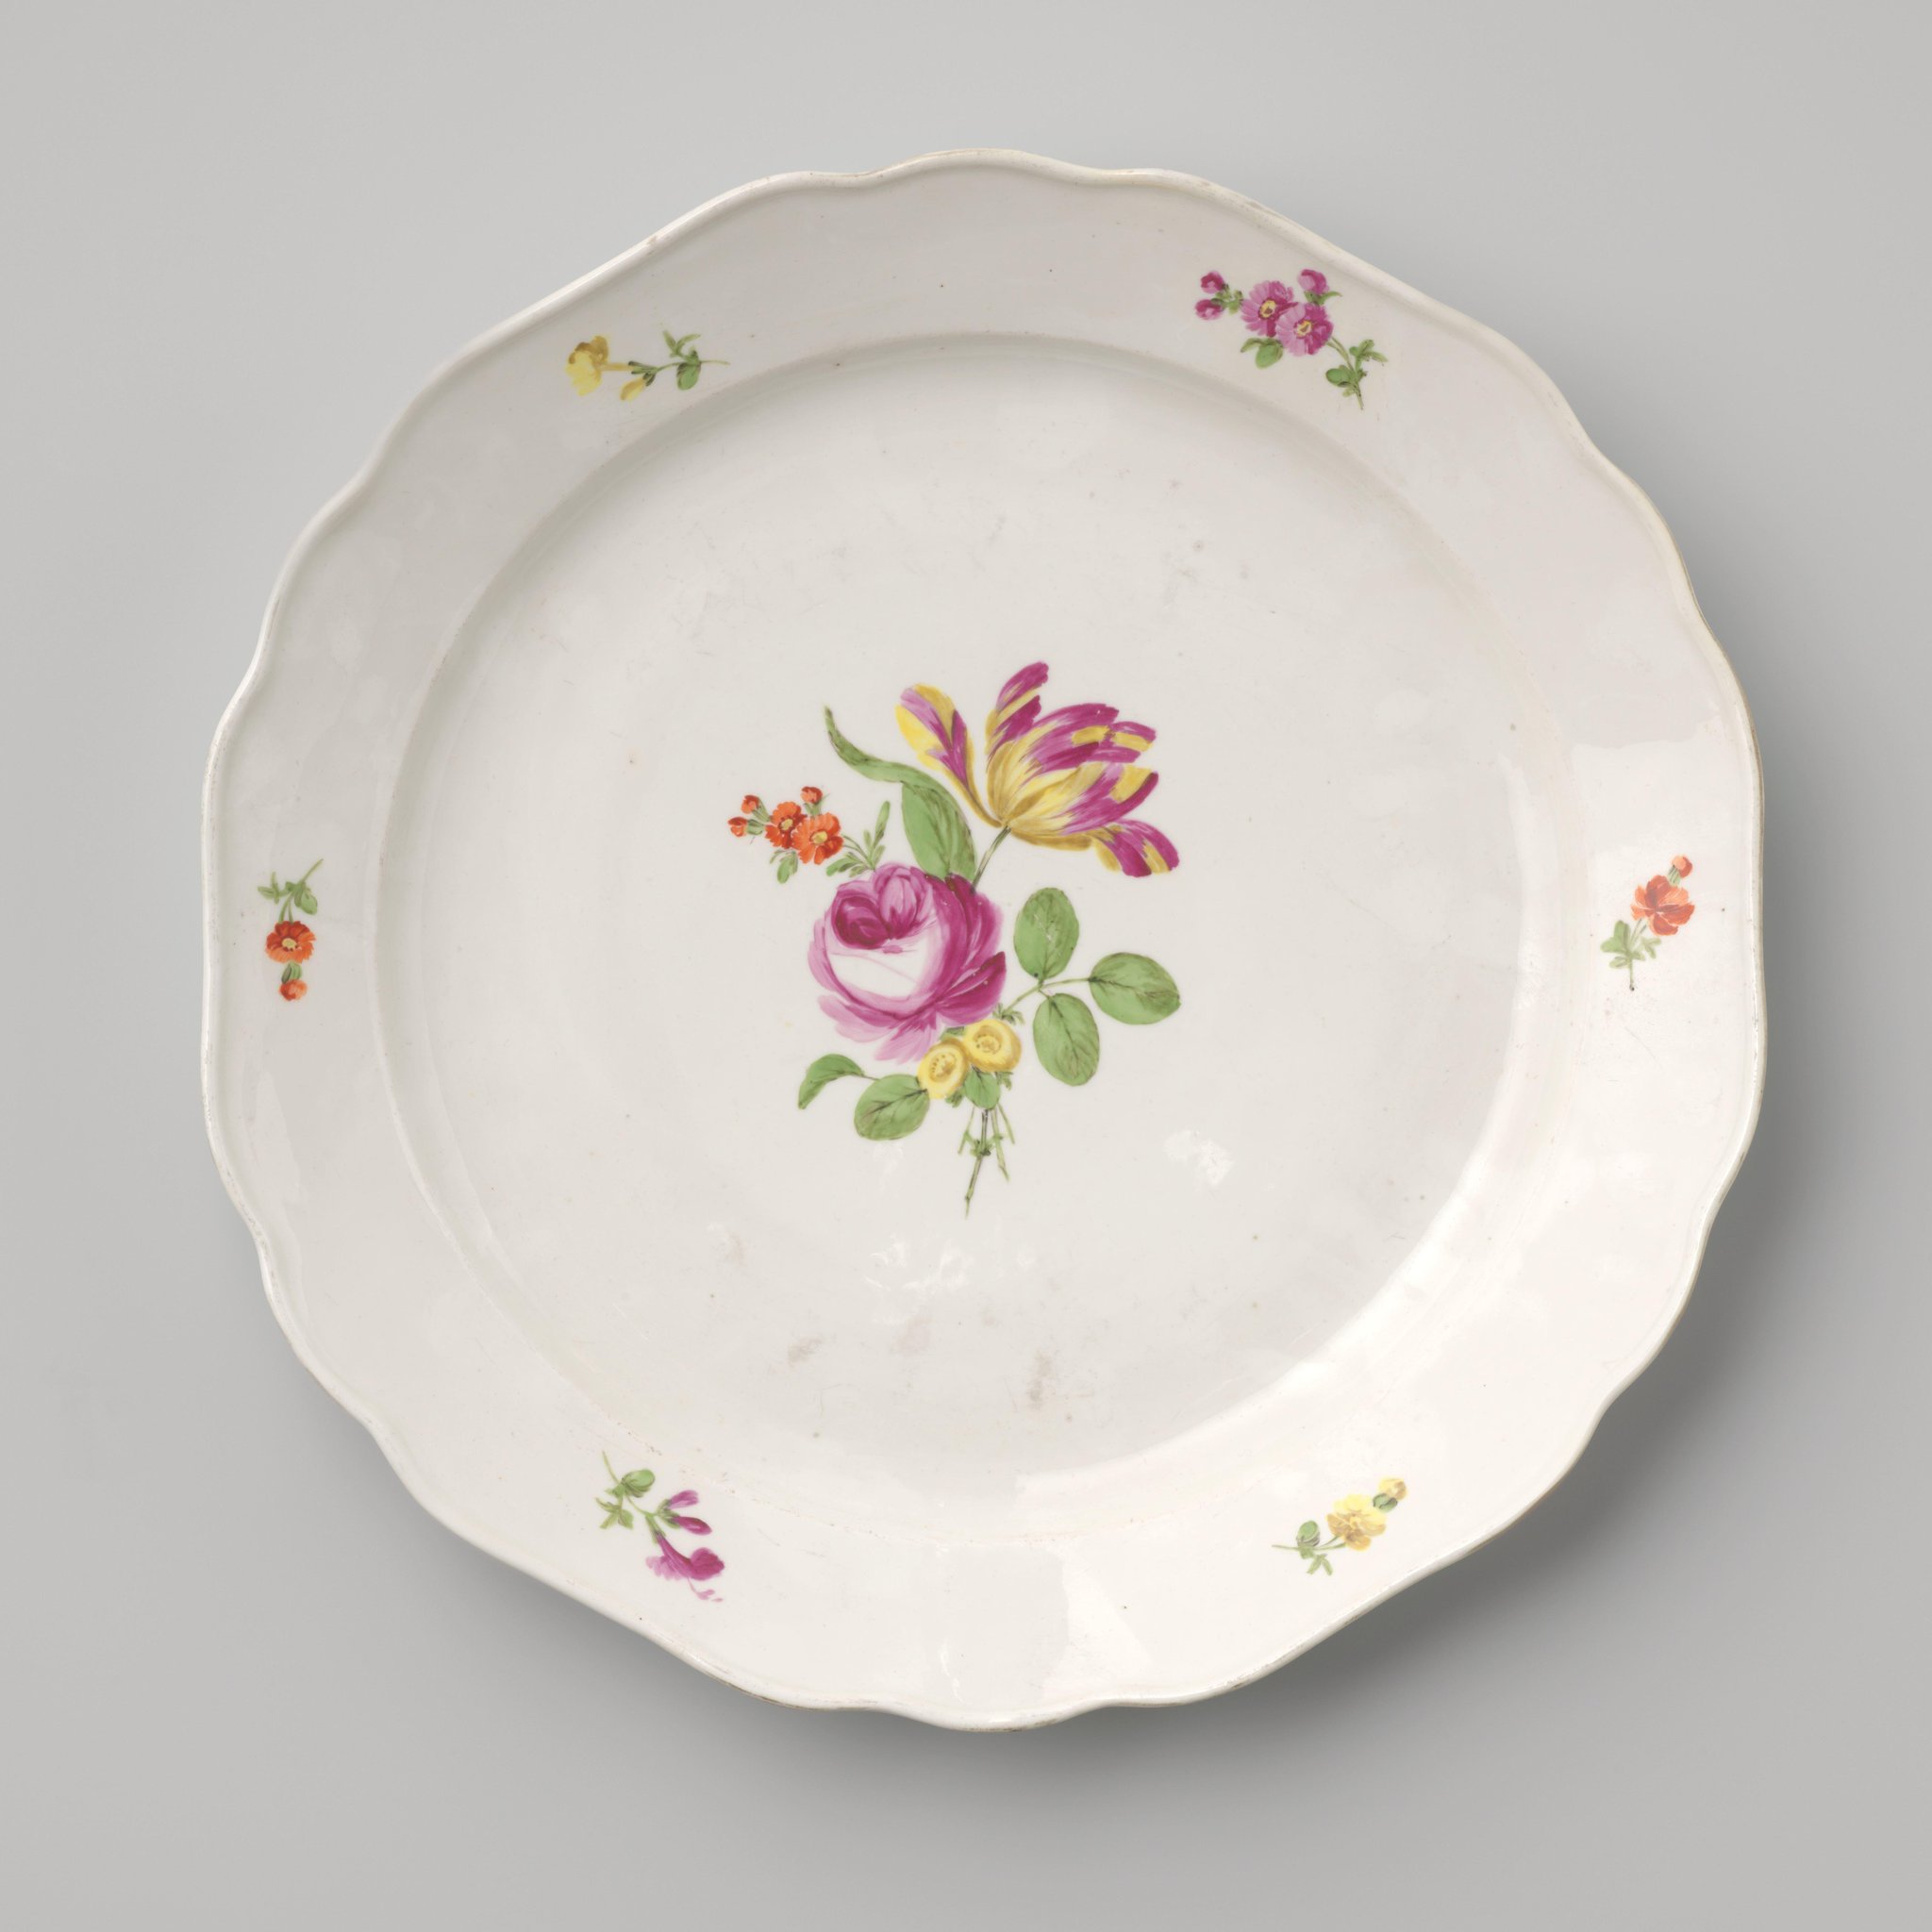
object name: platter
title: Dish with a bouquet and flower sprays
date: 1800-1849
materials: glaze, paint, porcelain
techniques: firing, forming, turning, vitrification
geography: vienna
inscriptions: mark: ‘schild/ P32/ 11/ 87’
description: Schotel van porselein met gelobde rand, beschilderd op het glazuur in rood, roze, groen, geel en paars. Op het plat een boeket van verschillende bloemen (o.a. pioenroos) en op de rand zes bloemtakken. Gemerkt op de onderzijde met het schild, P32 en de nummers 11 en 87.